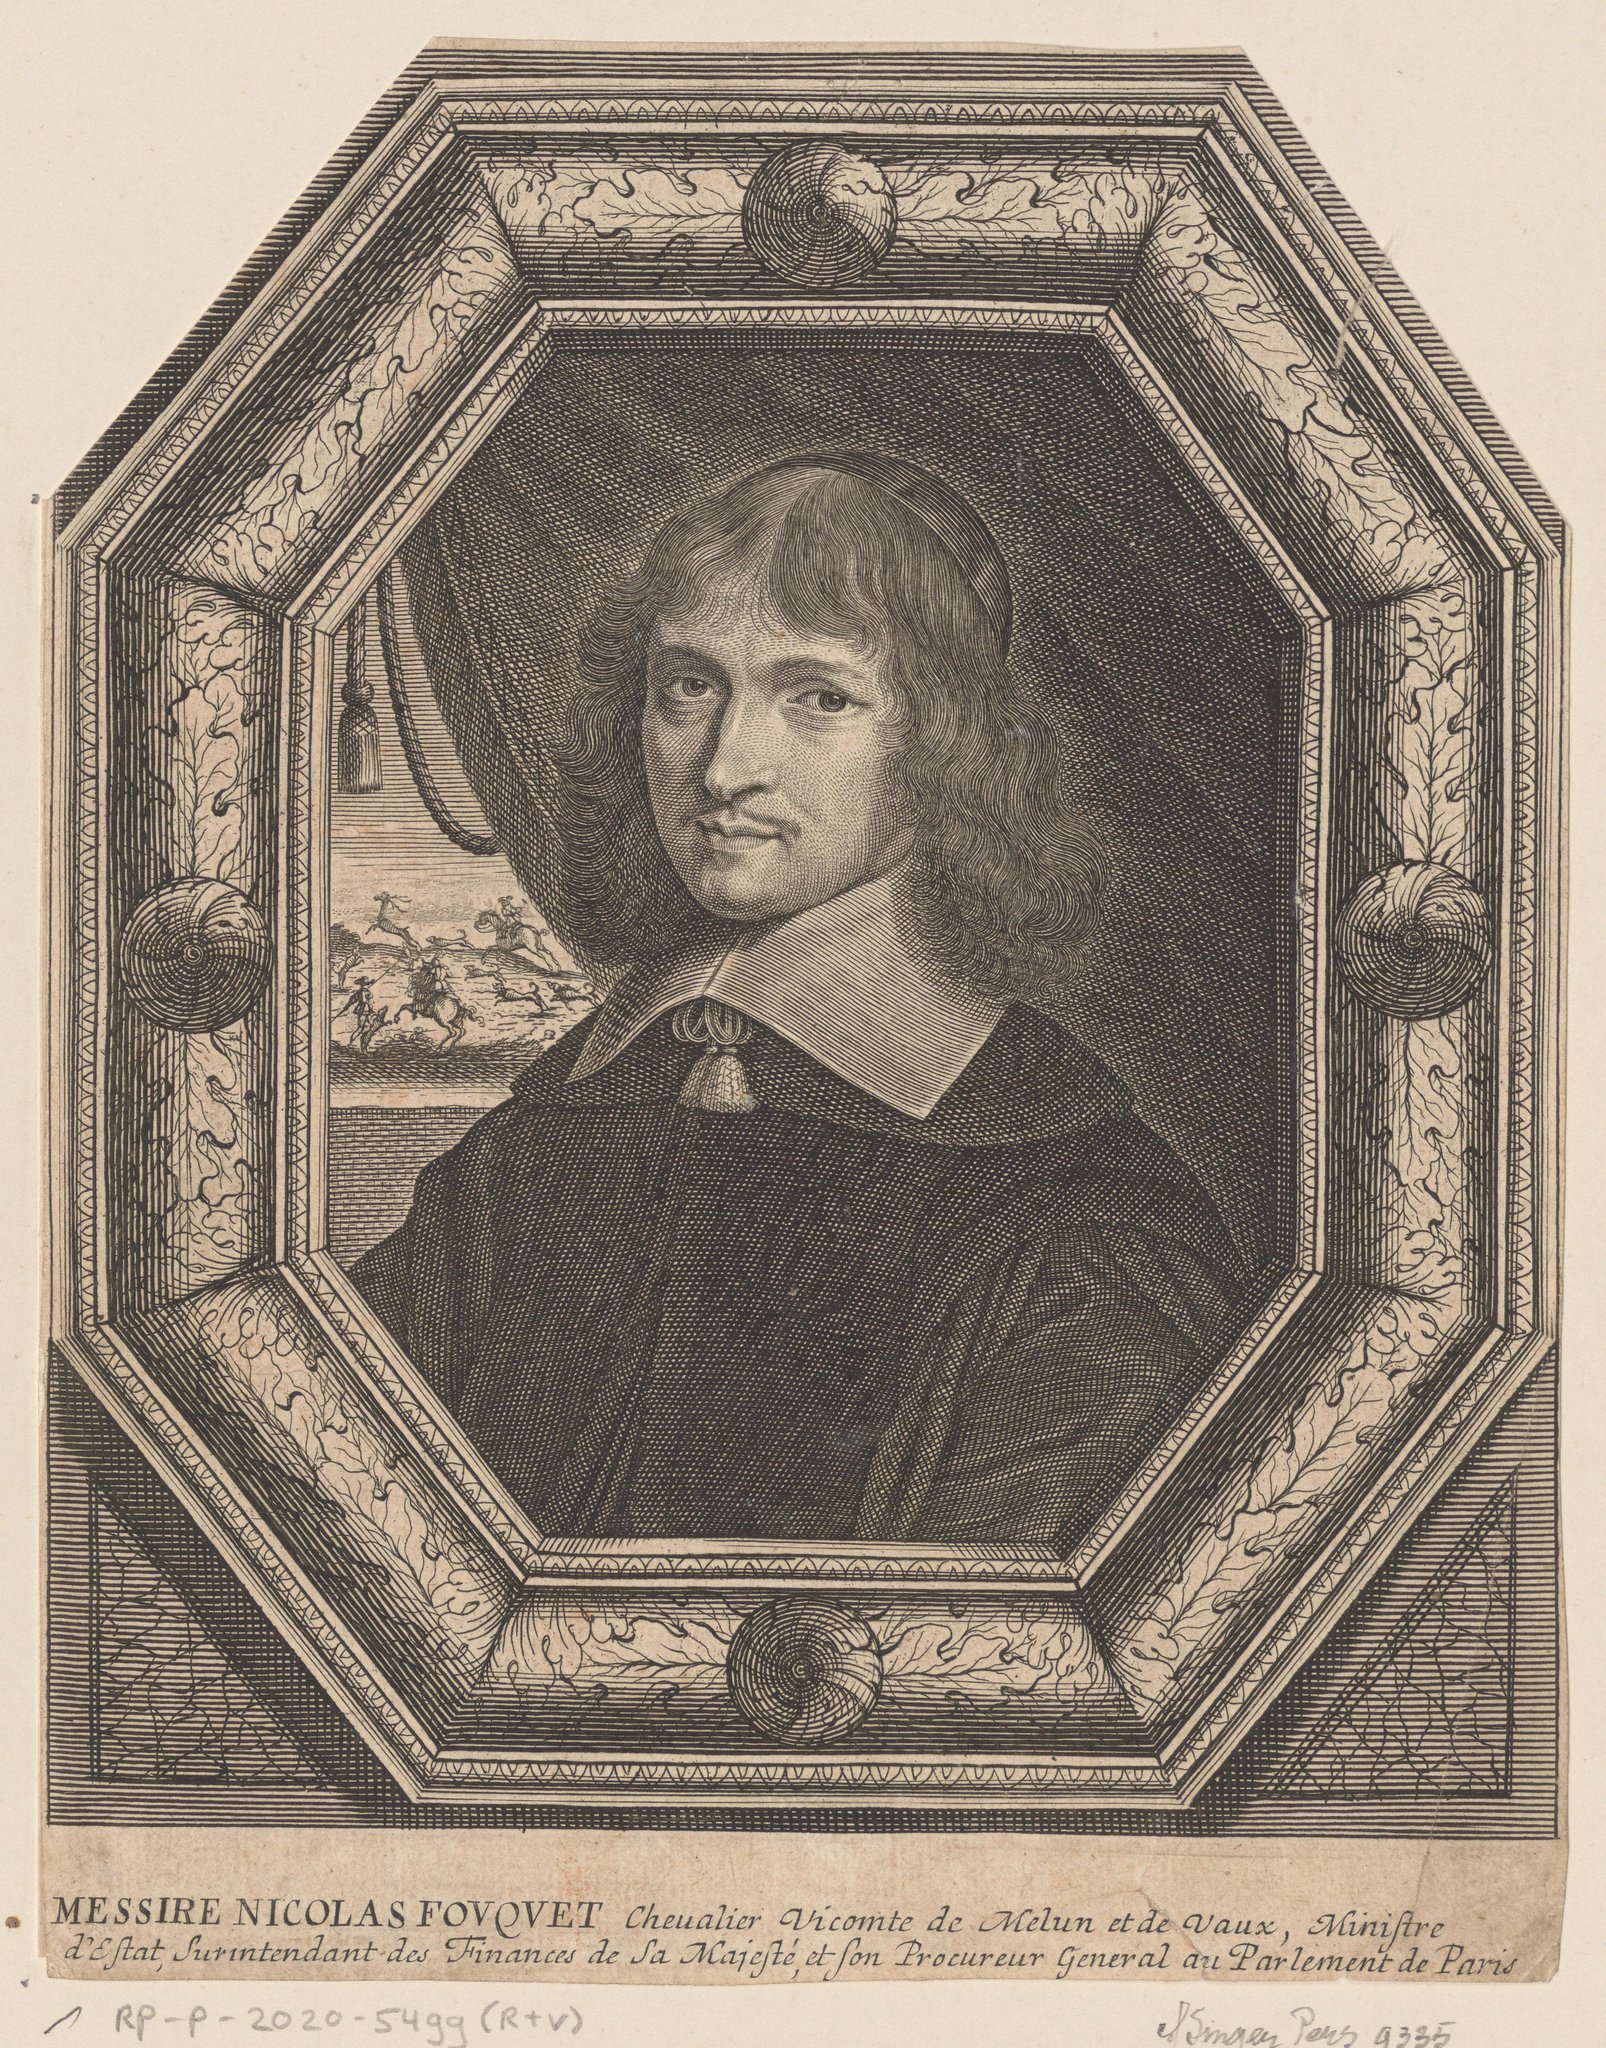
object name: print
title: Portret van Nicolas Fouquet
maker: Anonymous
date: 1653-1700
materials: paper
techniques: engraving, etching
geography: france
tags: paris, politician, nicolas fouquet, stag-hunting, historical persons, politician, e.g. party leader